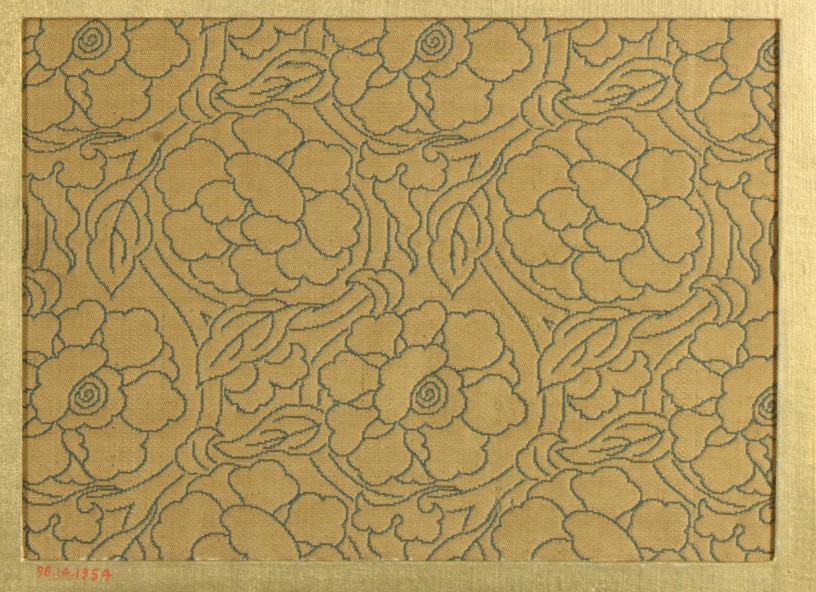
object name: piece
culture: japanese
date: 1701-1900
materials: silk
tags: flowers